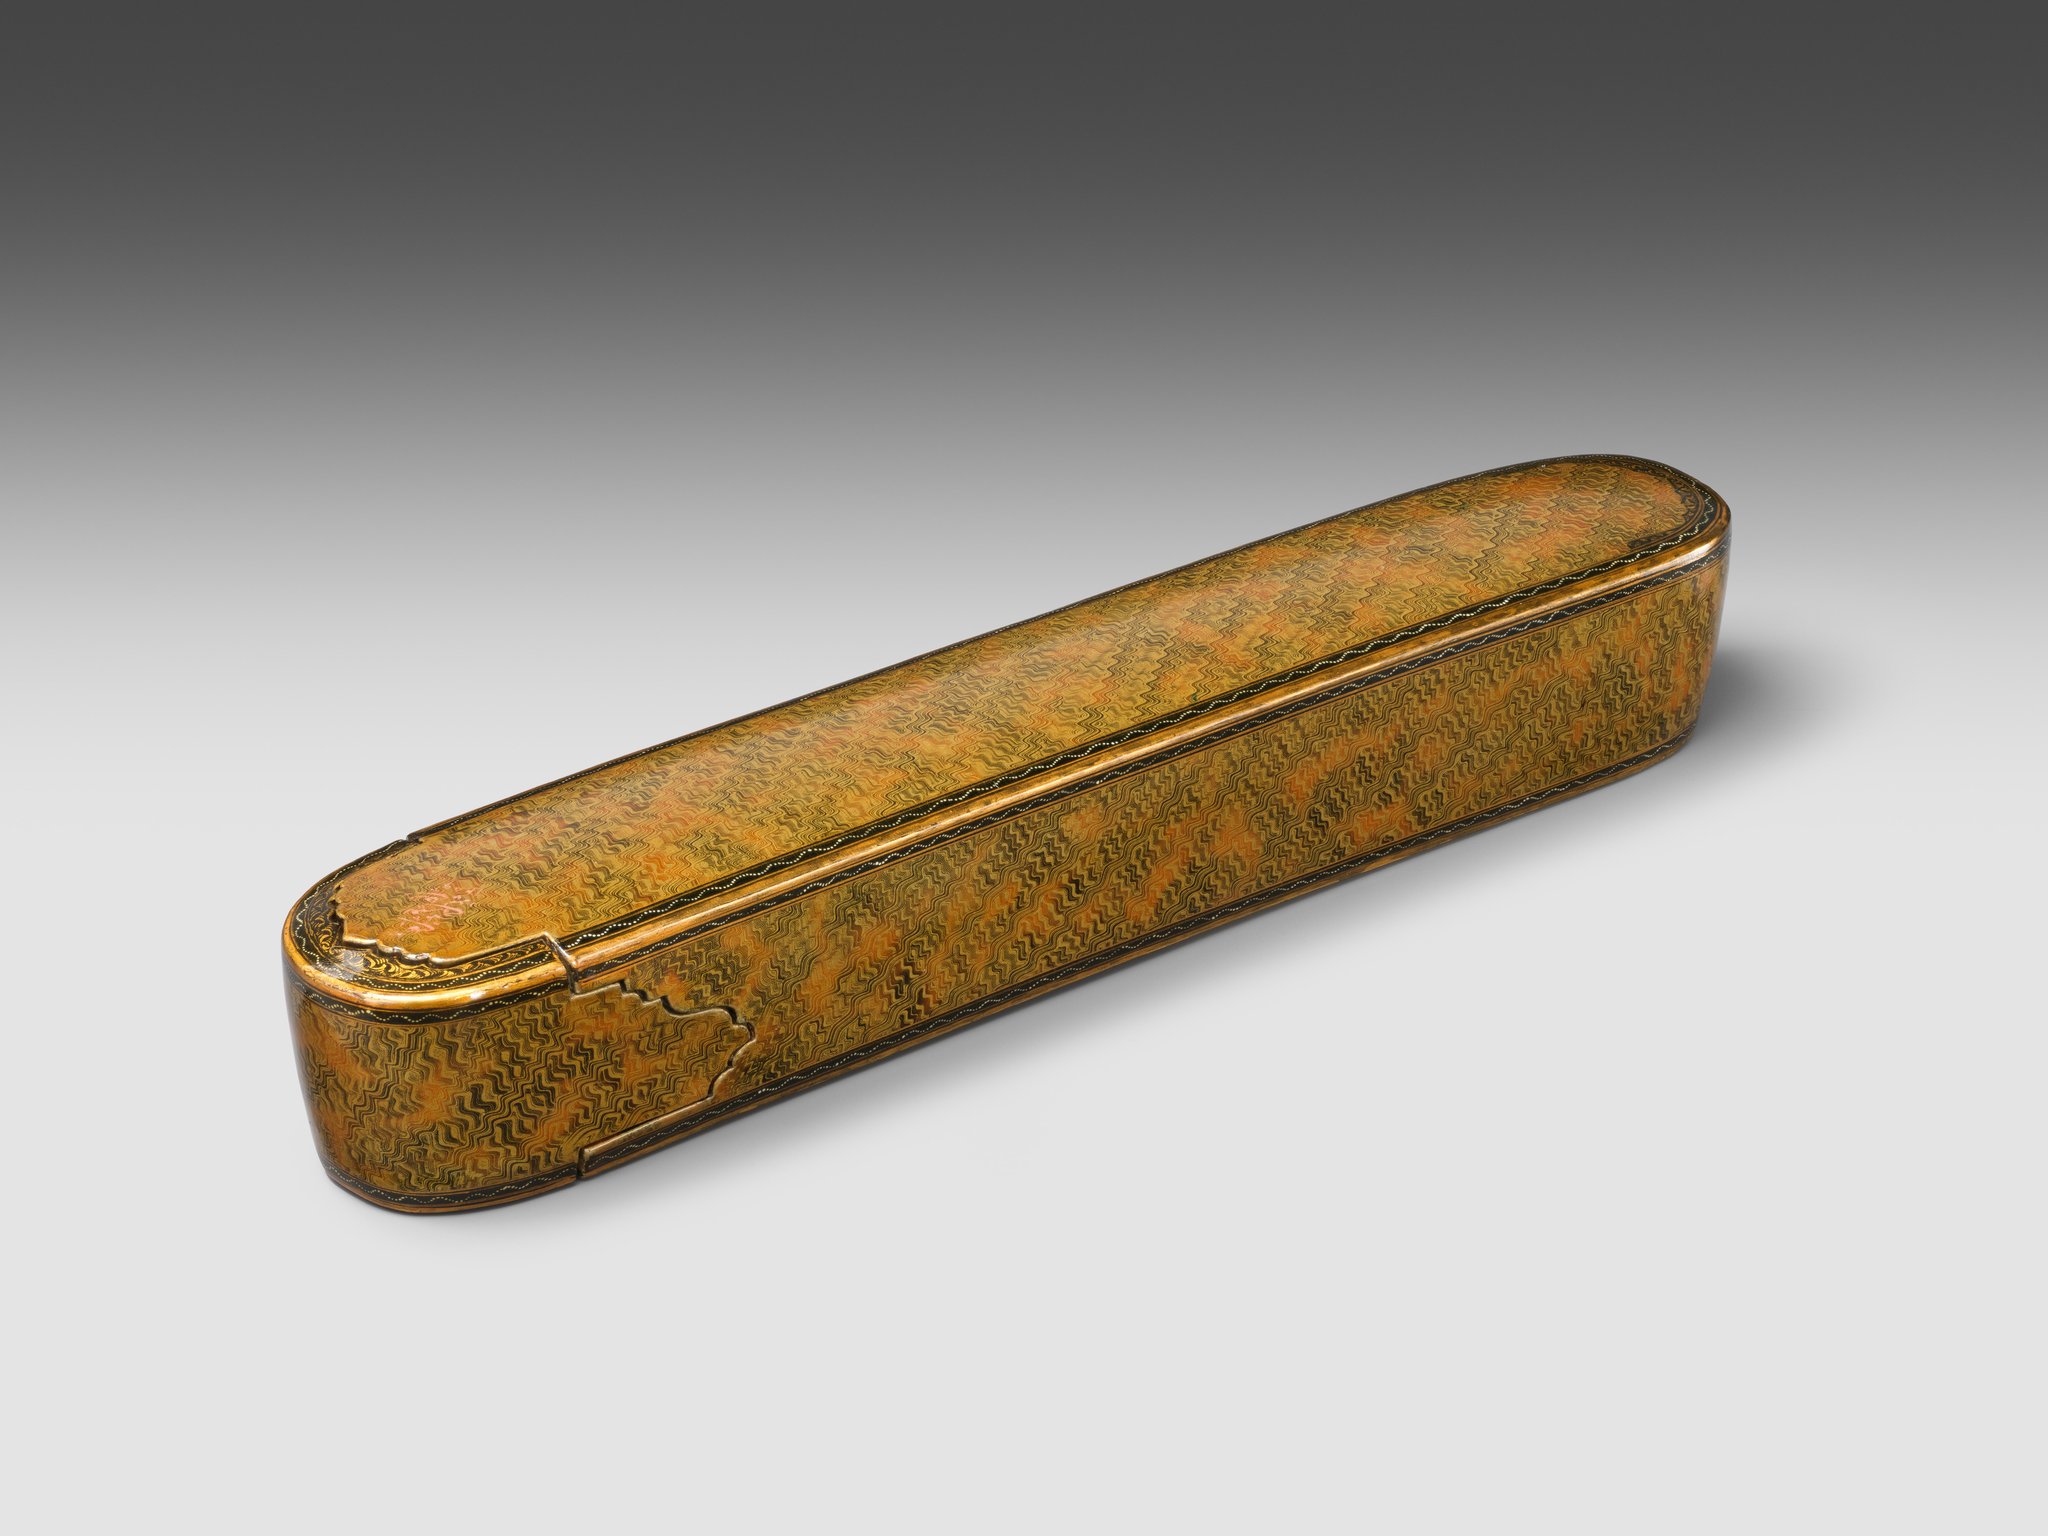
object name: pen box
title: Pen Box with Marbled Design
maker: rajab 'ali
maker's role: artist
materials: paper, varnish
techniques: gilding, painting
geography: iran